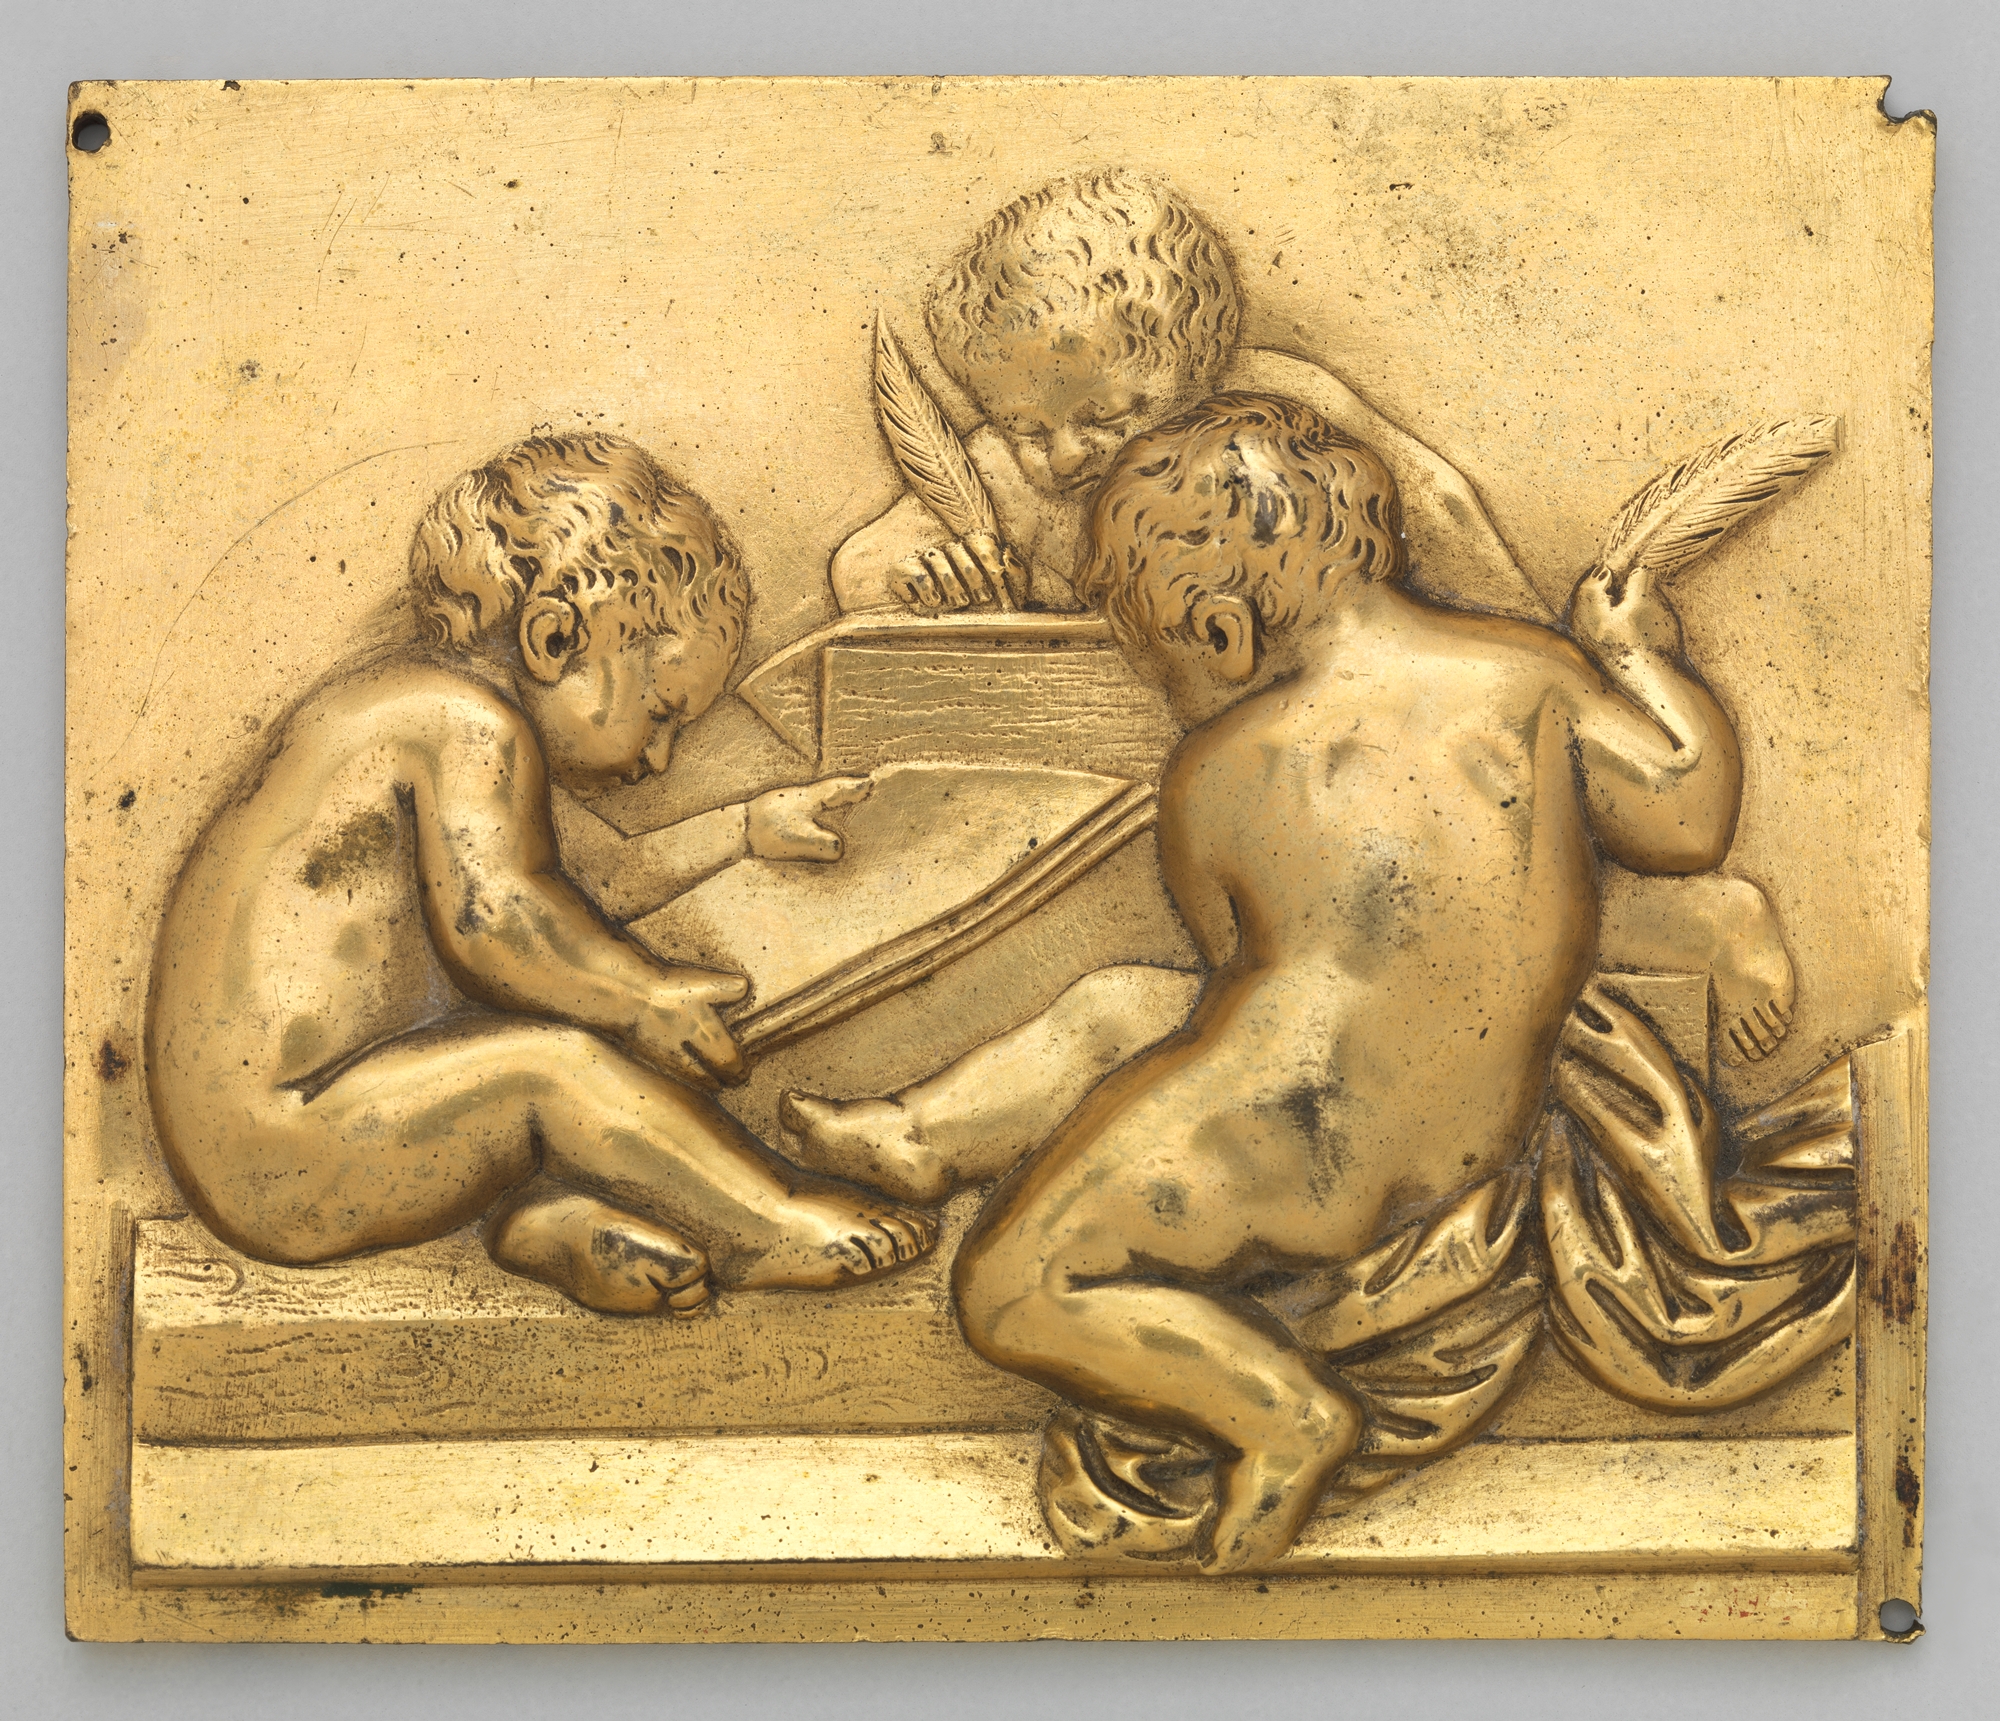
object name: frieze ornament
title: Frieze ornament depicting the theme of reading and writing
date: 1783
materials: gilt bronze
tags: boys,reading,writing